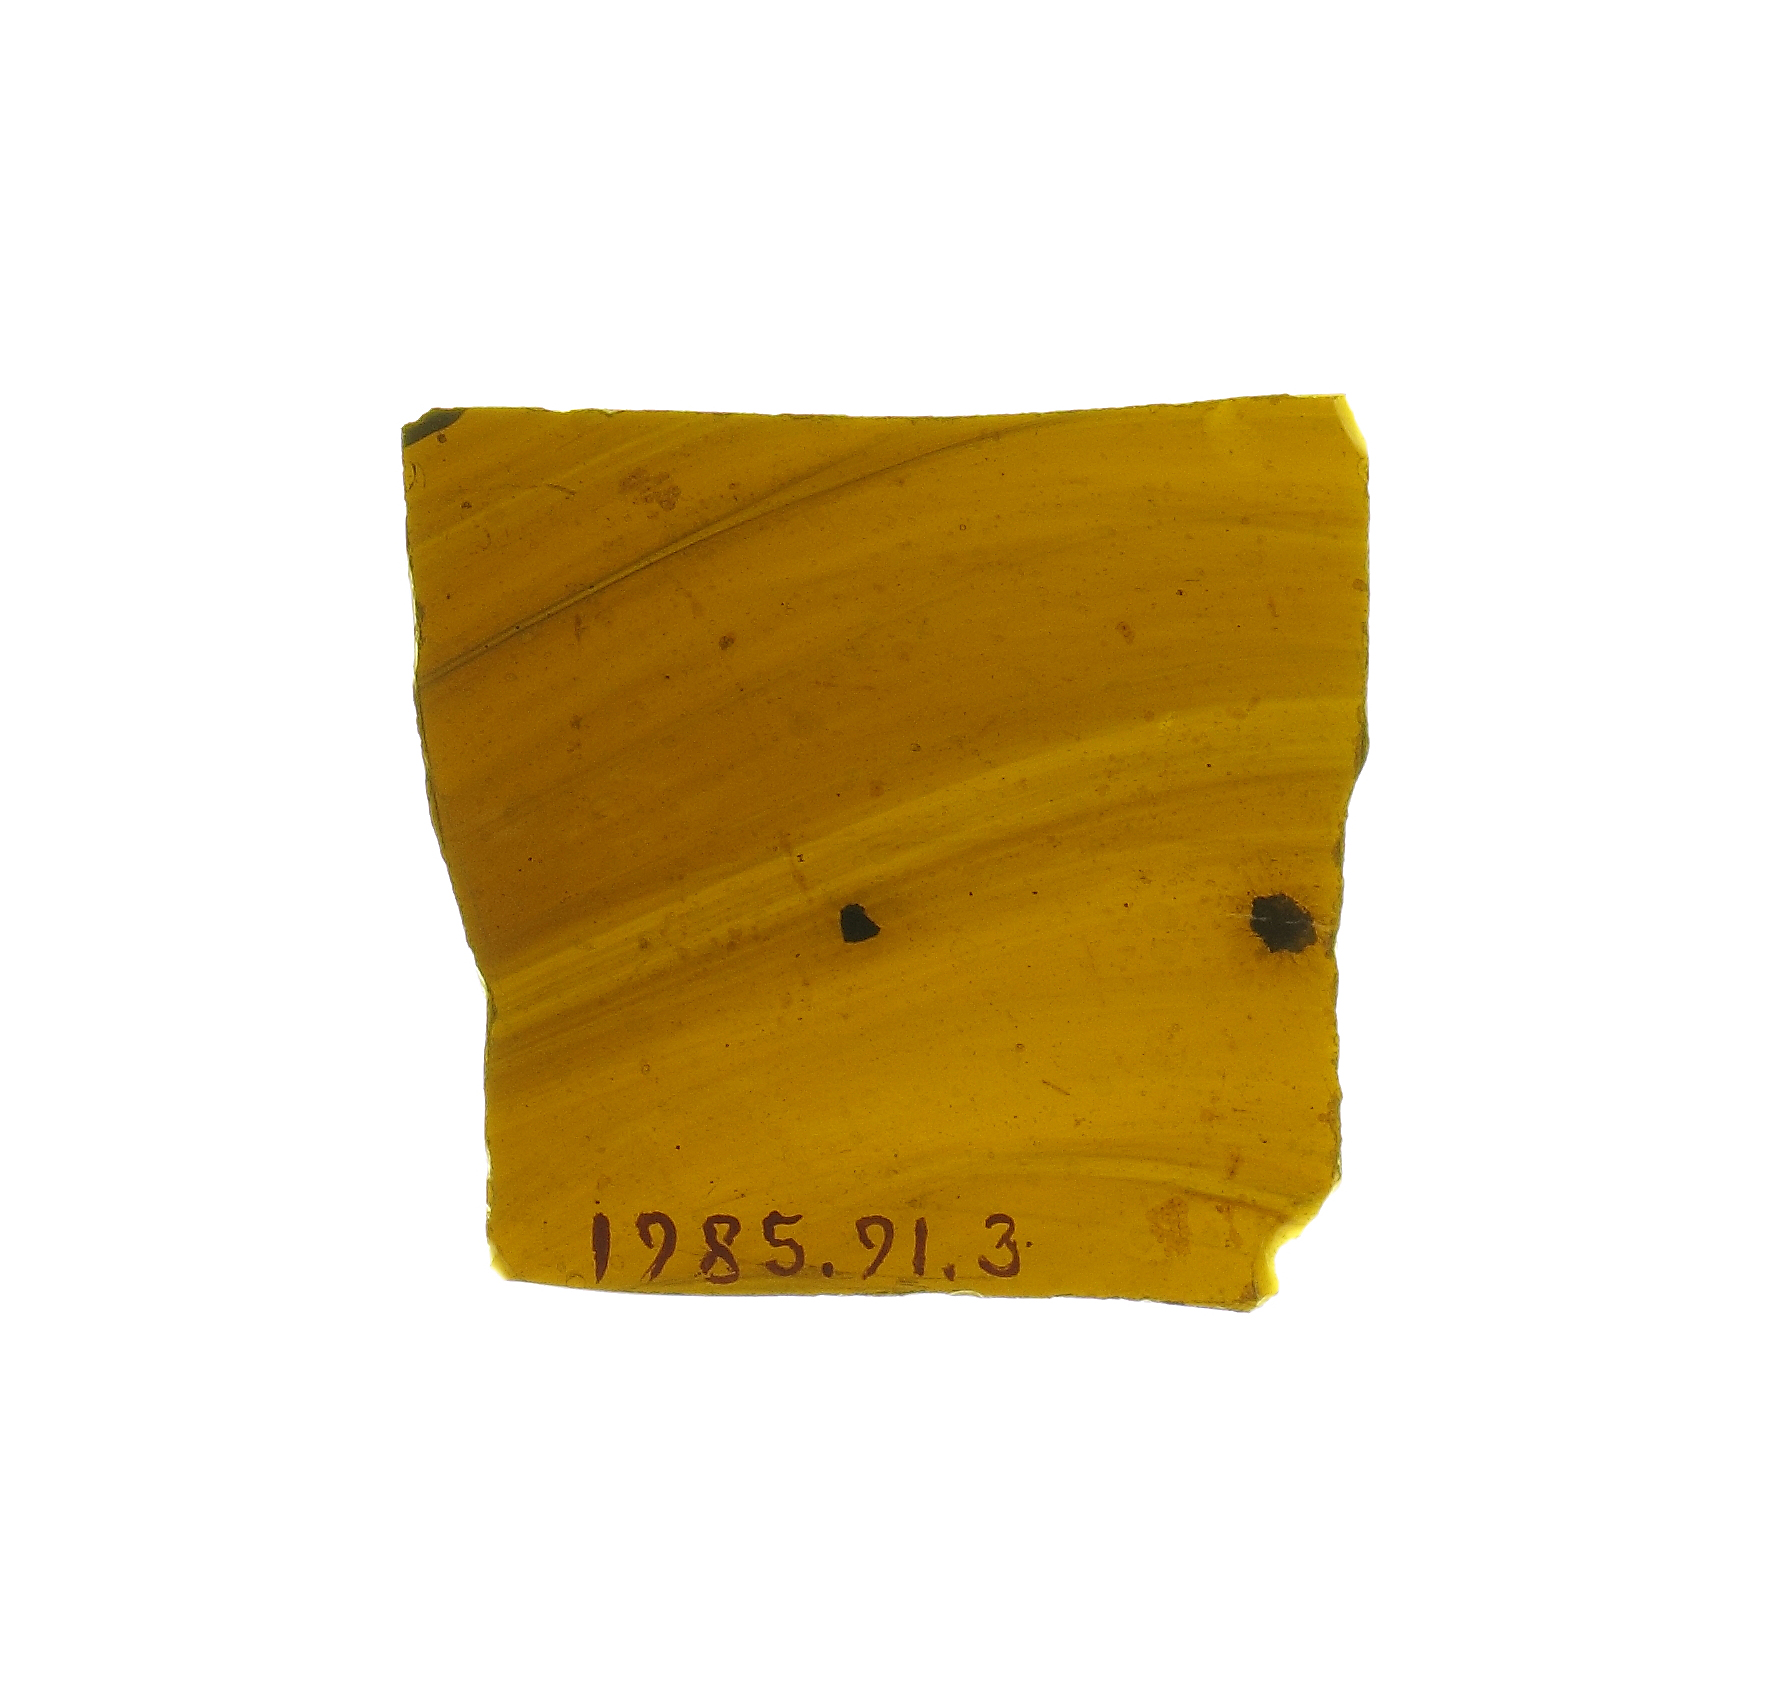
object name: fragment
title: Glass Fragment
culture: syrian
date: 701-800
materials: glass, metal, paint